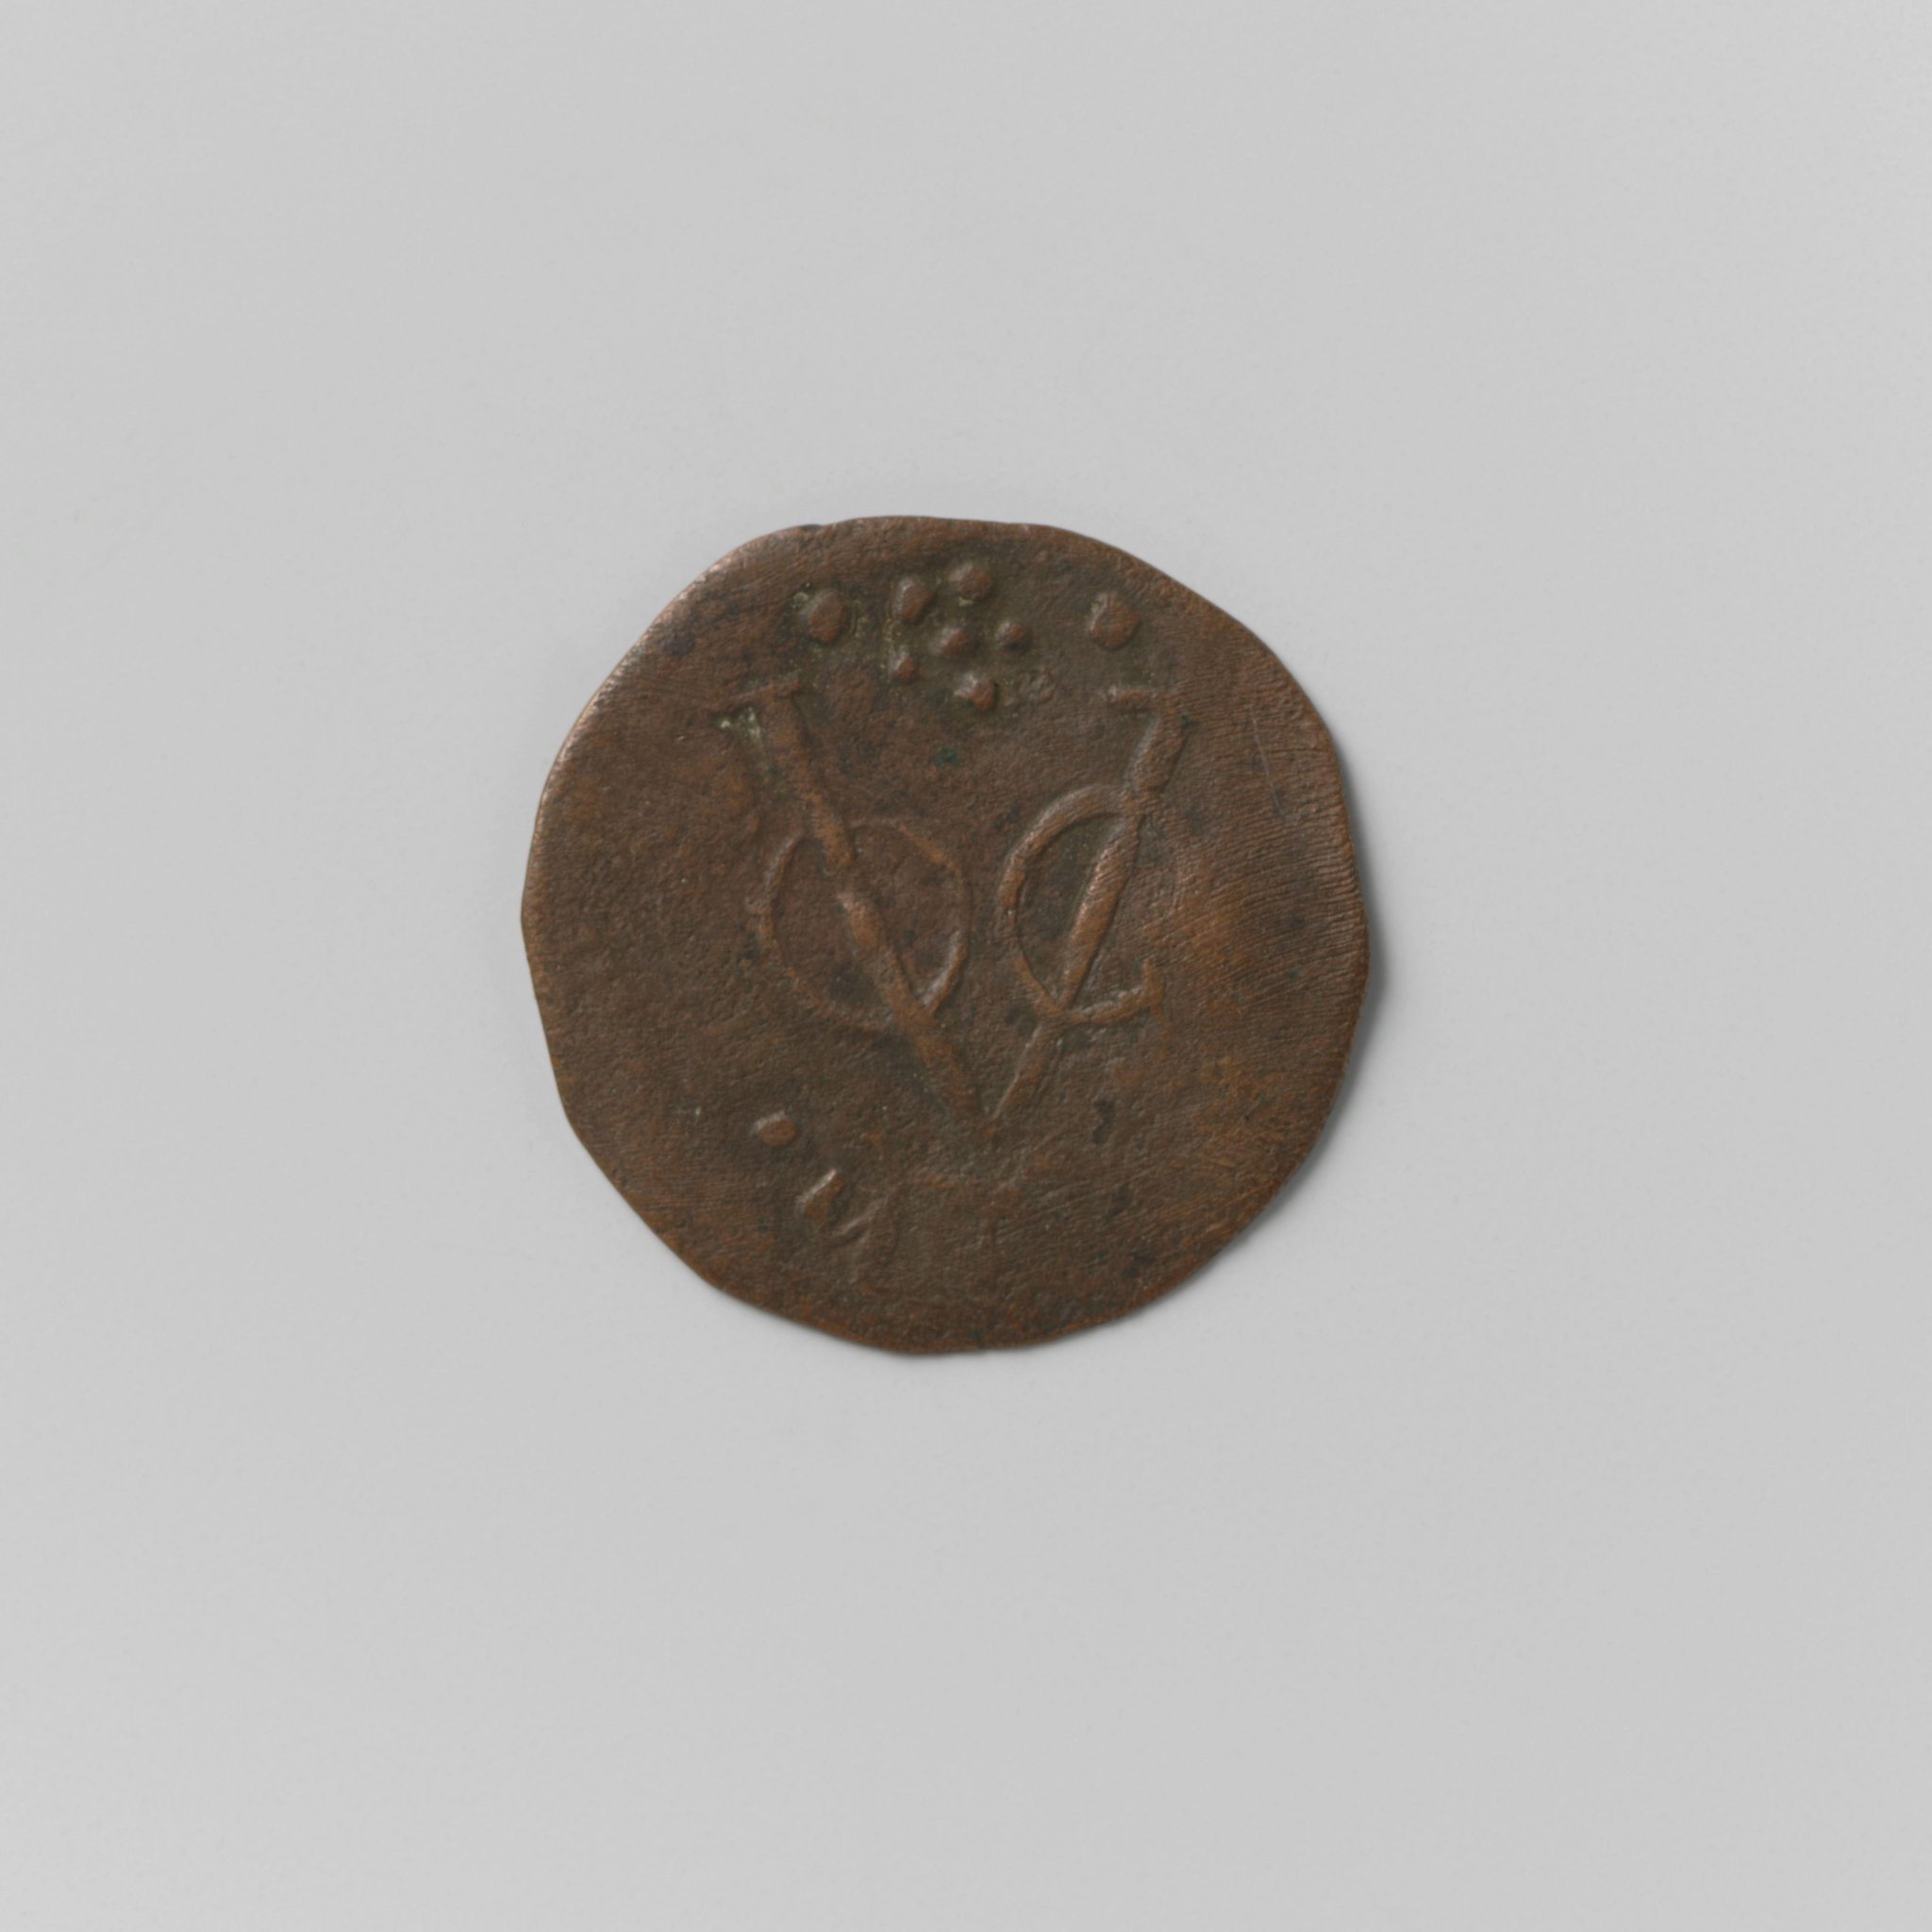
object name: coin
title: Naboootsing van ½ duit van de VOC uit Holland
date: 1780-1830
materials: copper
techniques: striking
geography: banjarmasin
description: Koperen munt. Nabootsing van duit van de VOC uit Holland. Voorzijde: gekroond wapenschild van Holland. Keerzijde: monogram van de VOC, waarboven punt en waaronder fictief jaartal.